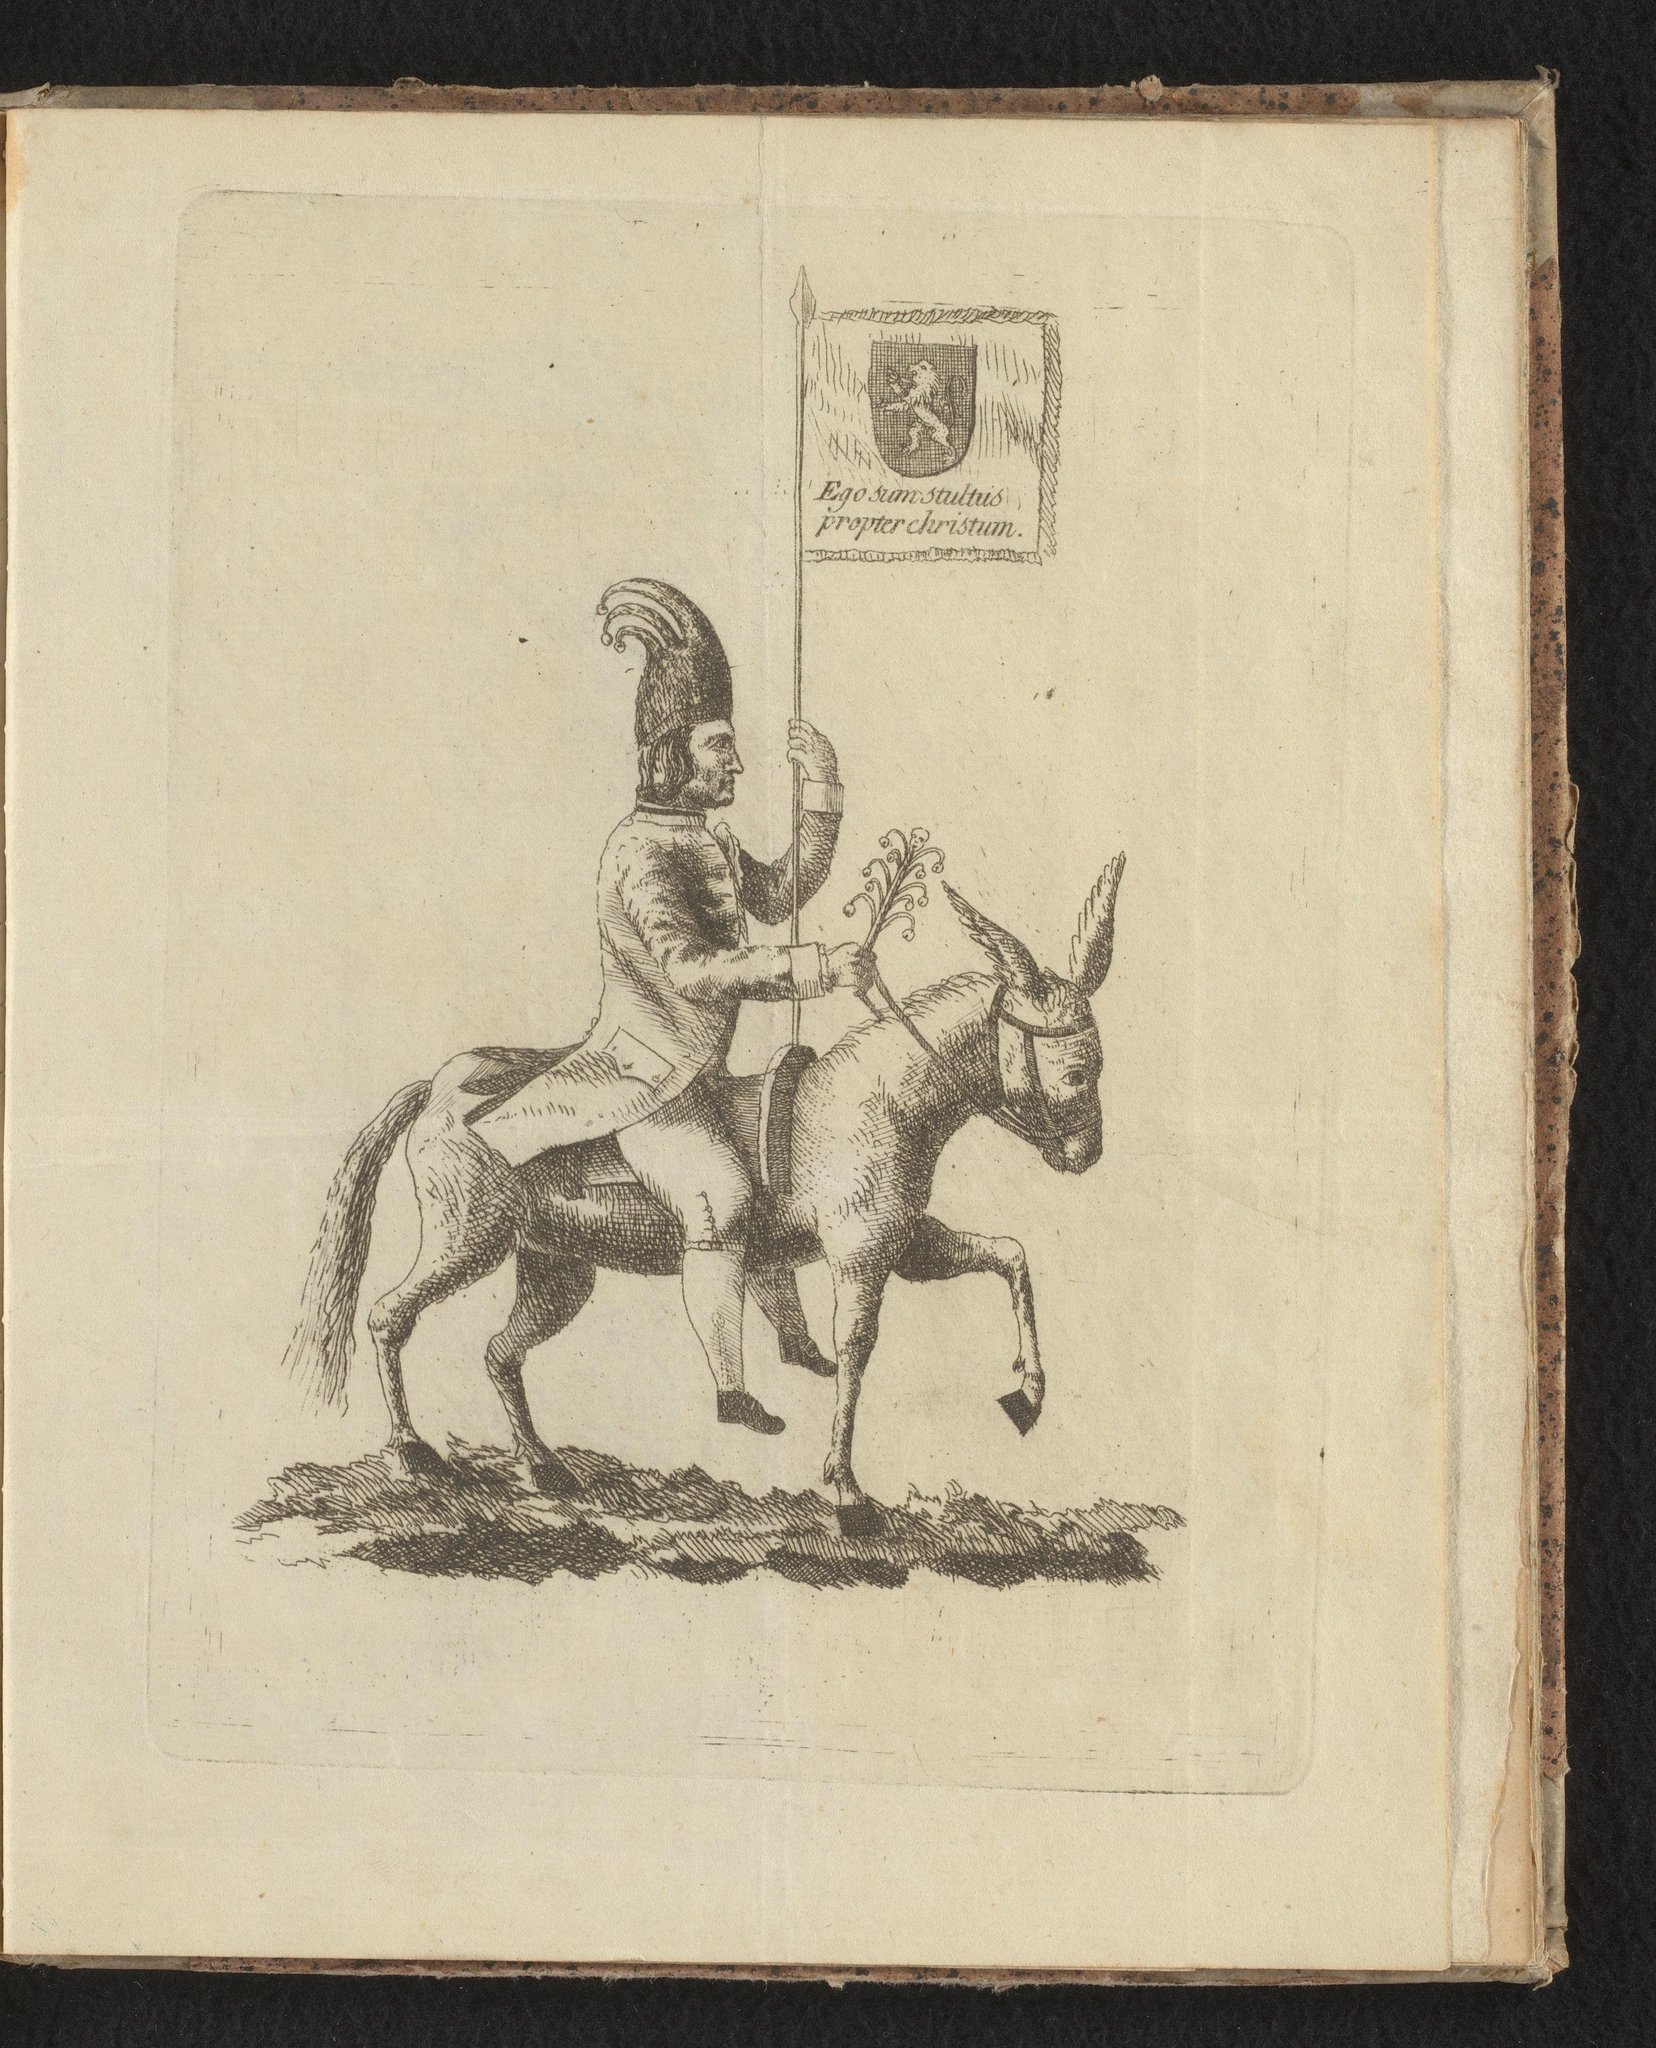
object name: print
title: Nar met vaandel op een ezel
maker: Anonymous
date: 1787-1790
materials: paper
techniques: engraving, etching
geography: southern netherlands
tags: antwerp, riding a horse, ass, or mule; rider, horseman, court jester, court fool, brabant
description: Een man met narrenmuts en vaandel in de hand rijdt op een ezel. Mogelijk is hier P.J.S. van Eupen voorgesteld. Onderdeel van de gebundelde verzameling prenten betrekking hebbend op de gebeurtenissen van de Brabantse Omwenteling en de periode 1787-1790.